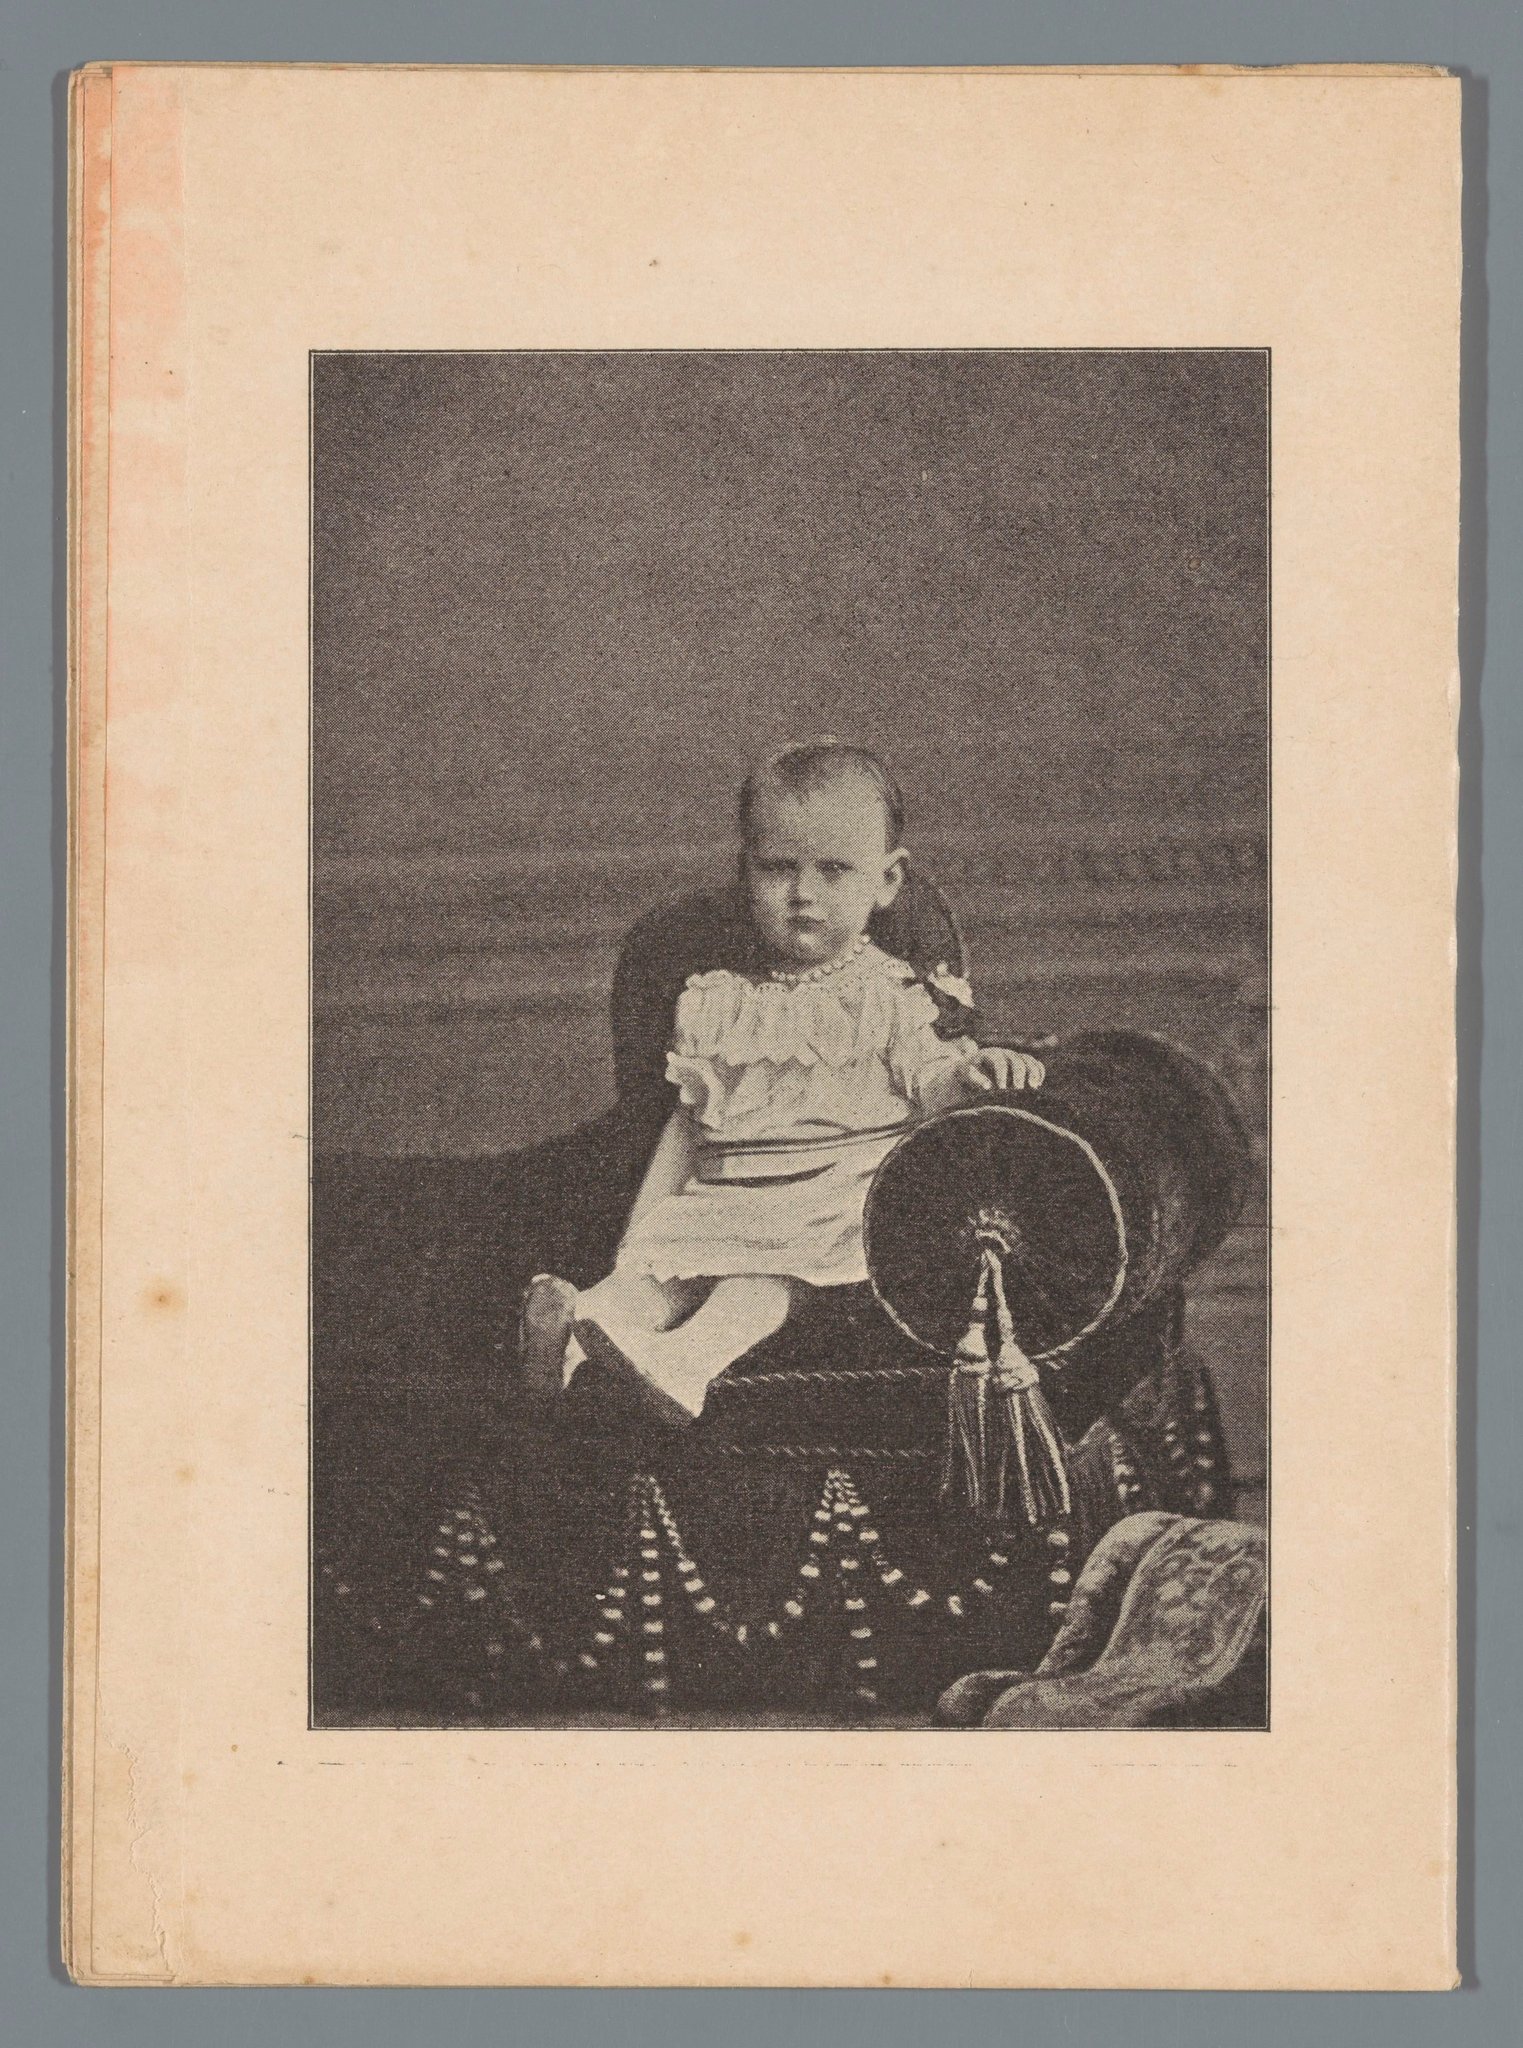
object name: photomechanical print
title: Leporelloalbum met veertien portretten van koningin Wilhelmina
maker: Anonymous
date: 1882-1898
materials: paper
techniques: autotype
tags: the hague, wilhelmina of the netherlands, queen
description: Een reeks van veertien uitvouwbare portretten van prinses Wilhelmina in haar jeugd op chronologische volgorde. Omslag is eraf.